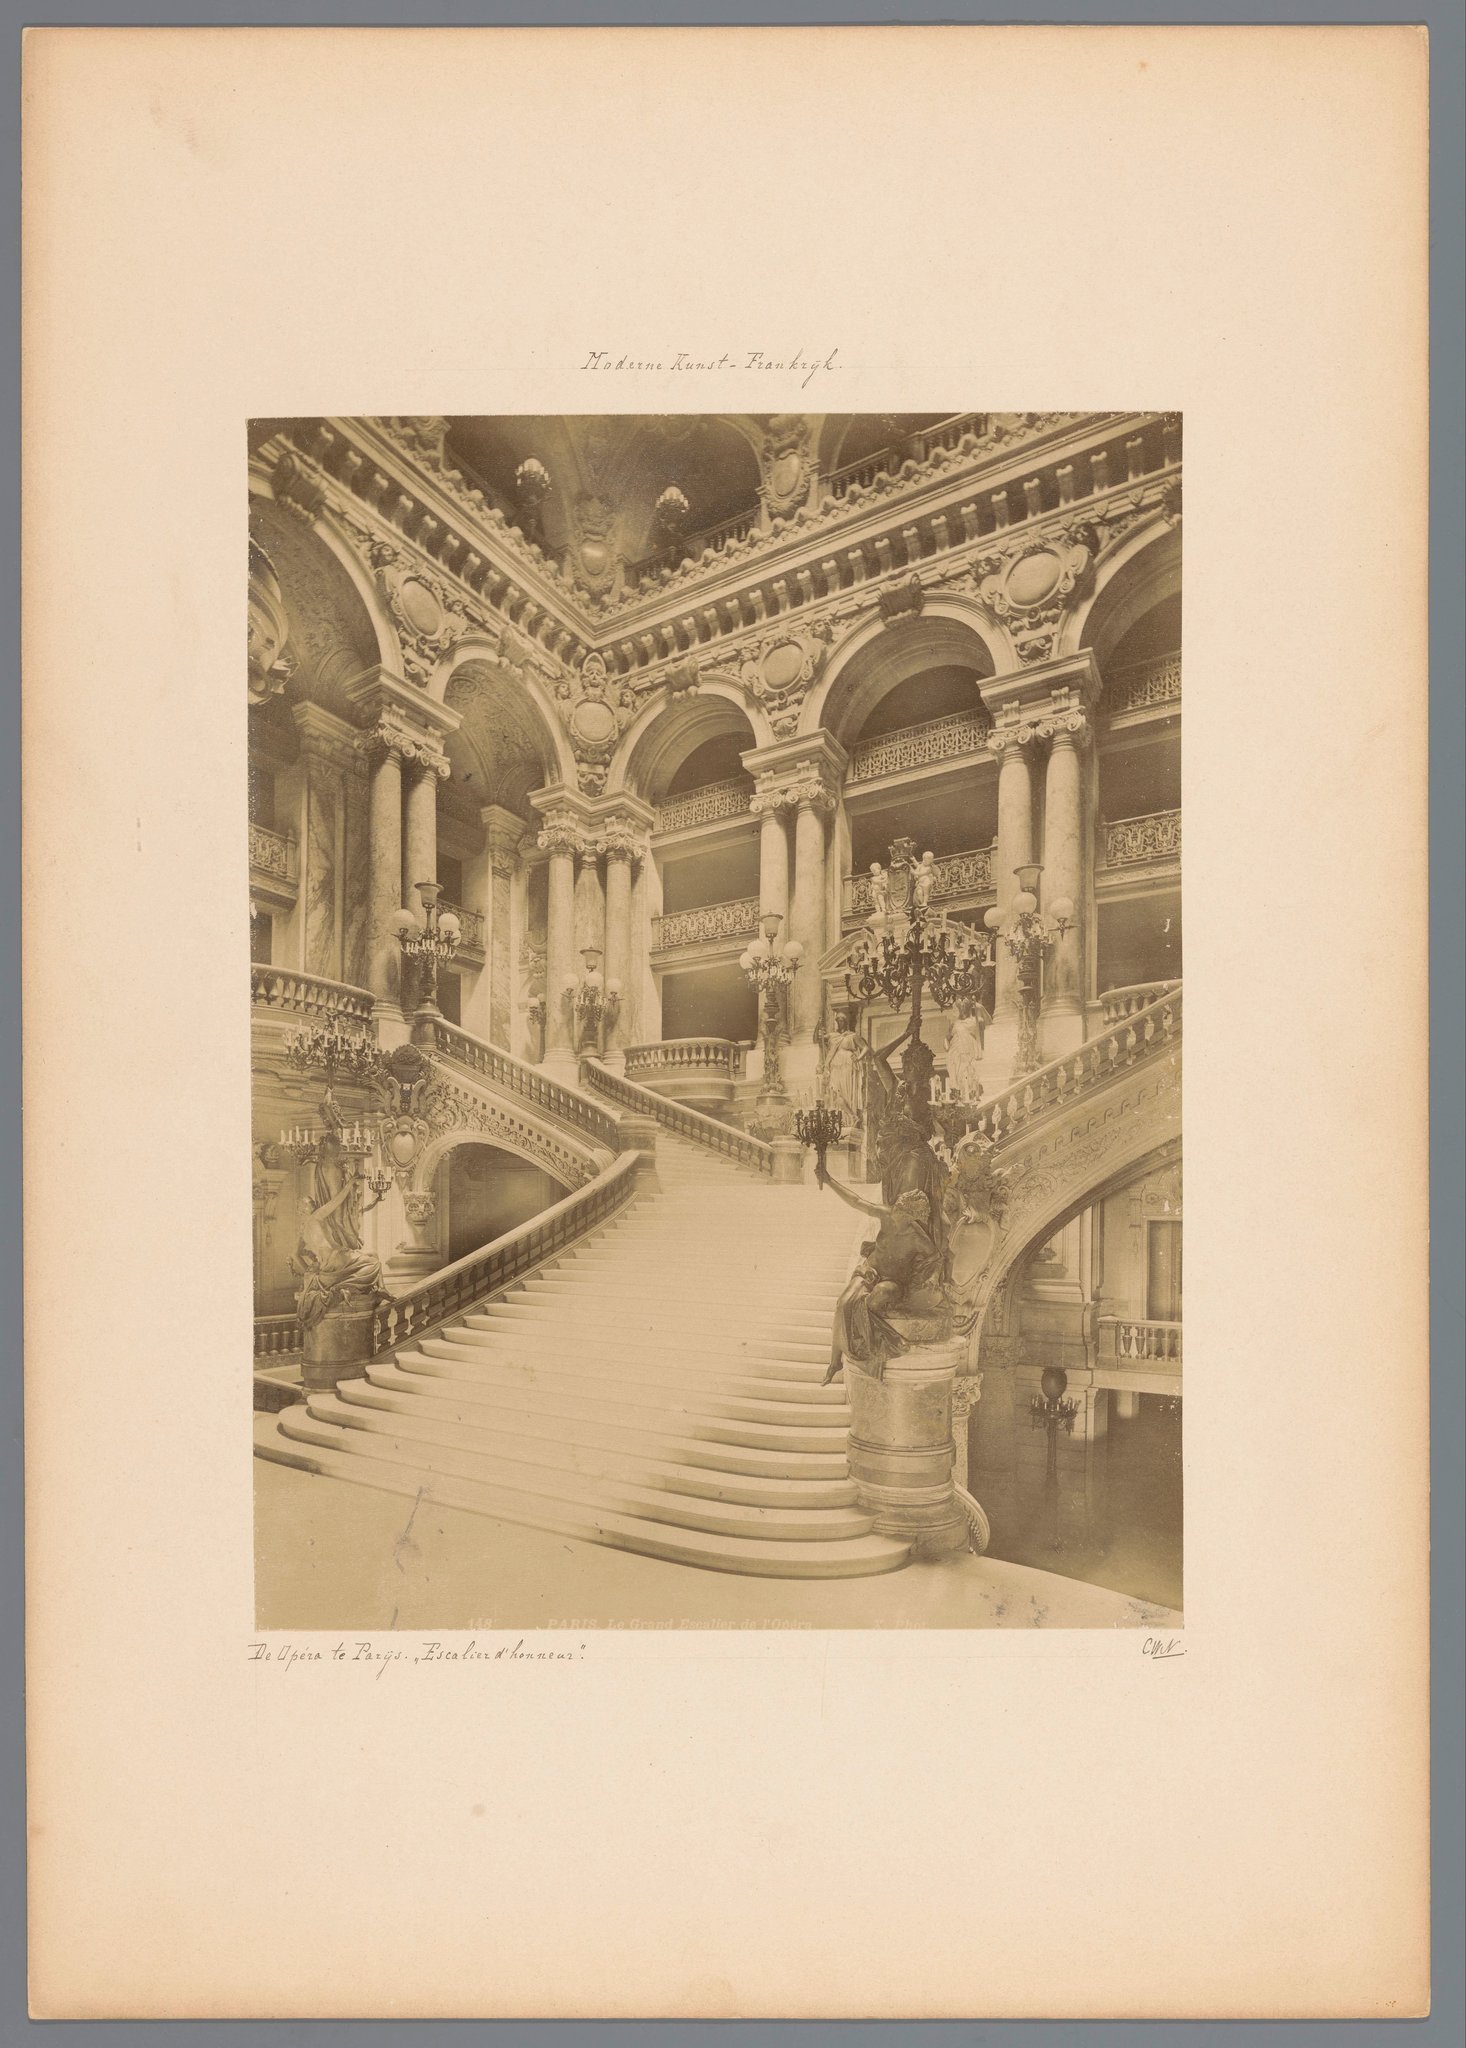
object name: photograph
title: Trap in de Opéra Garnier te Parijs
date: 1875-1900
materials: cardboard, photographic support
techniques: albumen print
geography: paris opera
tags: staircase, lighting; lamps, interior ~ representation of a building, opera house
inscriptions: inscription: ‘CWN.’, collector's mark: ‘KUNSTNIJVERHEIDSCHOOL QUELLINUS AMSTERDAM FRANS HALSSTRAAT 14.’, collector's mark: ‘INSTITUUT VOOR KUNST- NIJVERHEIDSONDERWIJS GABRIËL METSUSTRAAT No. 16. AMSTERDAM’, inscription: ‘Moderne Kunst - Frankrijk. De Opéra te Parijs ,, Escalier d'honneur''.’, number: ‘148’